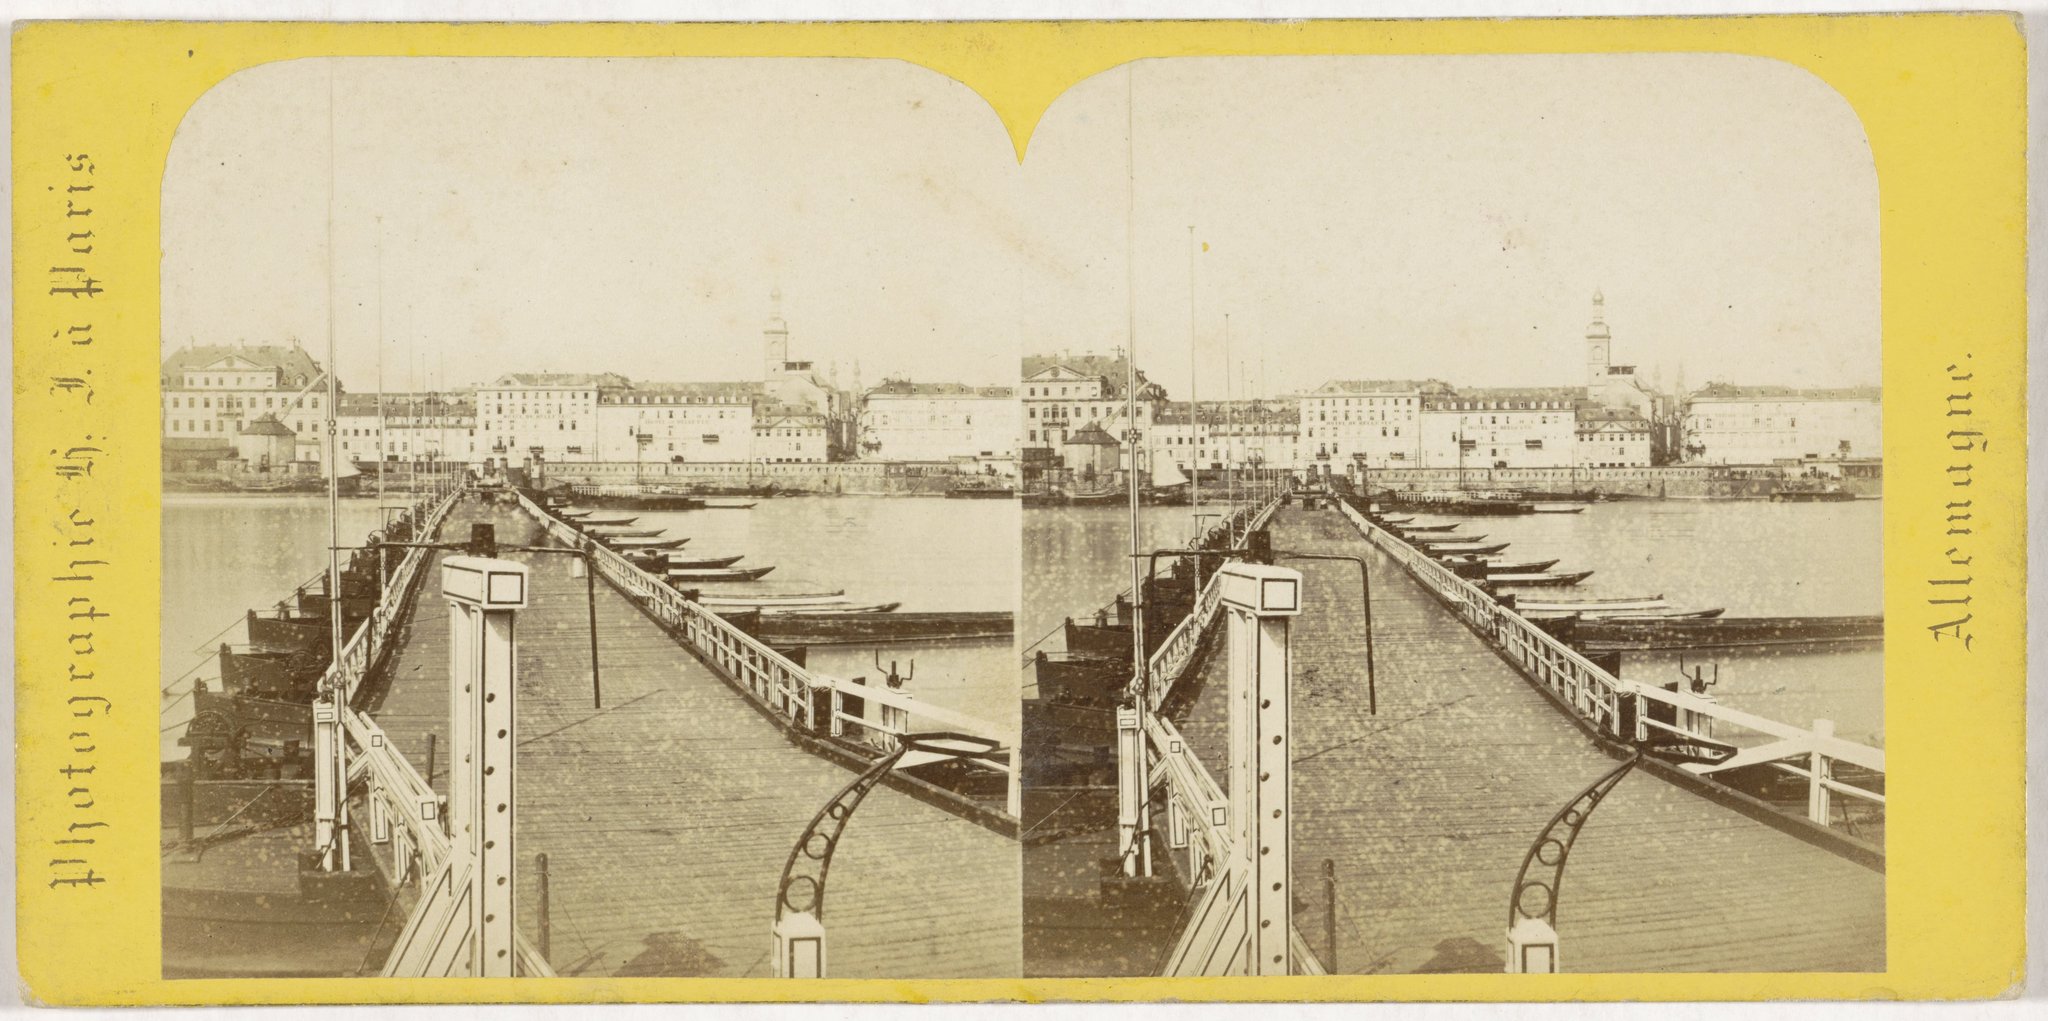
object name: stereograph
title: Vue générale de Coblentz, prise de la rive droite du Rhin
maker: hippolyte jouvin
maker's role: fotograaf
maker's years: 1825-1889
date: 1864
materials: cardboard, paper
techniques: albumen print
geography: koblenz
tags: city-view in general; 'veduta', pontoon bridge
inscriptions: inscription: ‘Déposé.’, number: ‘N. 543’